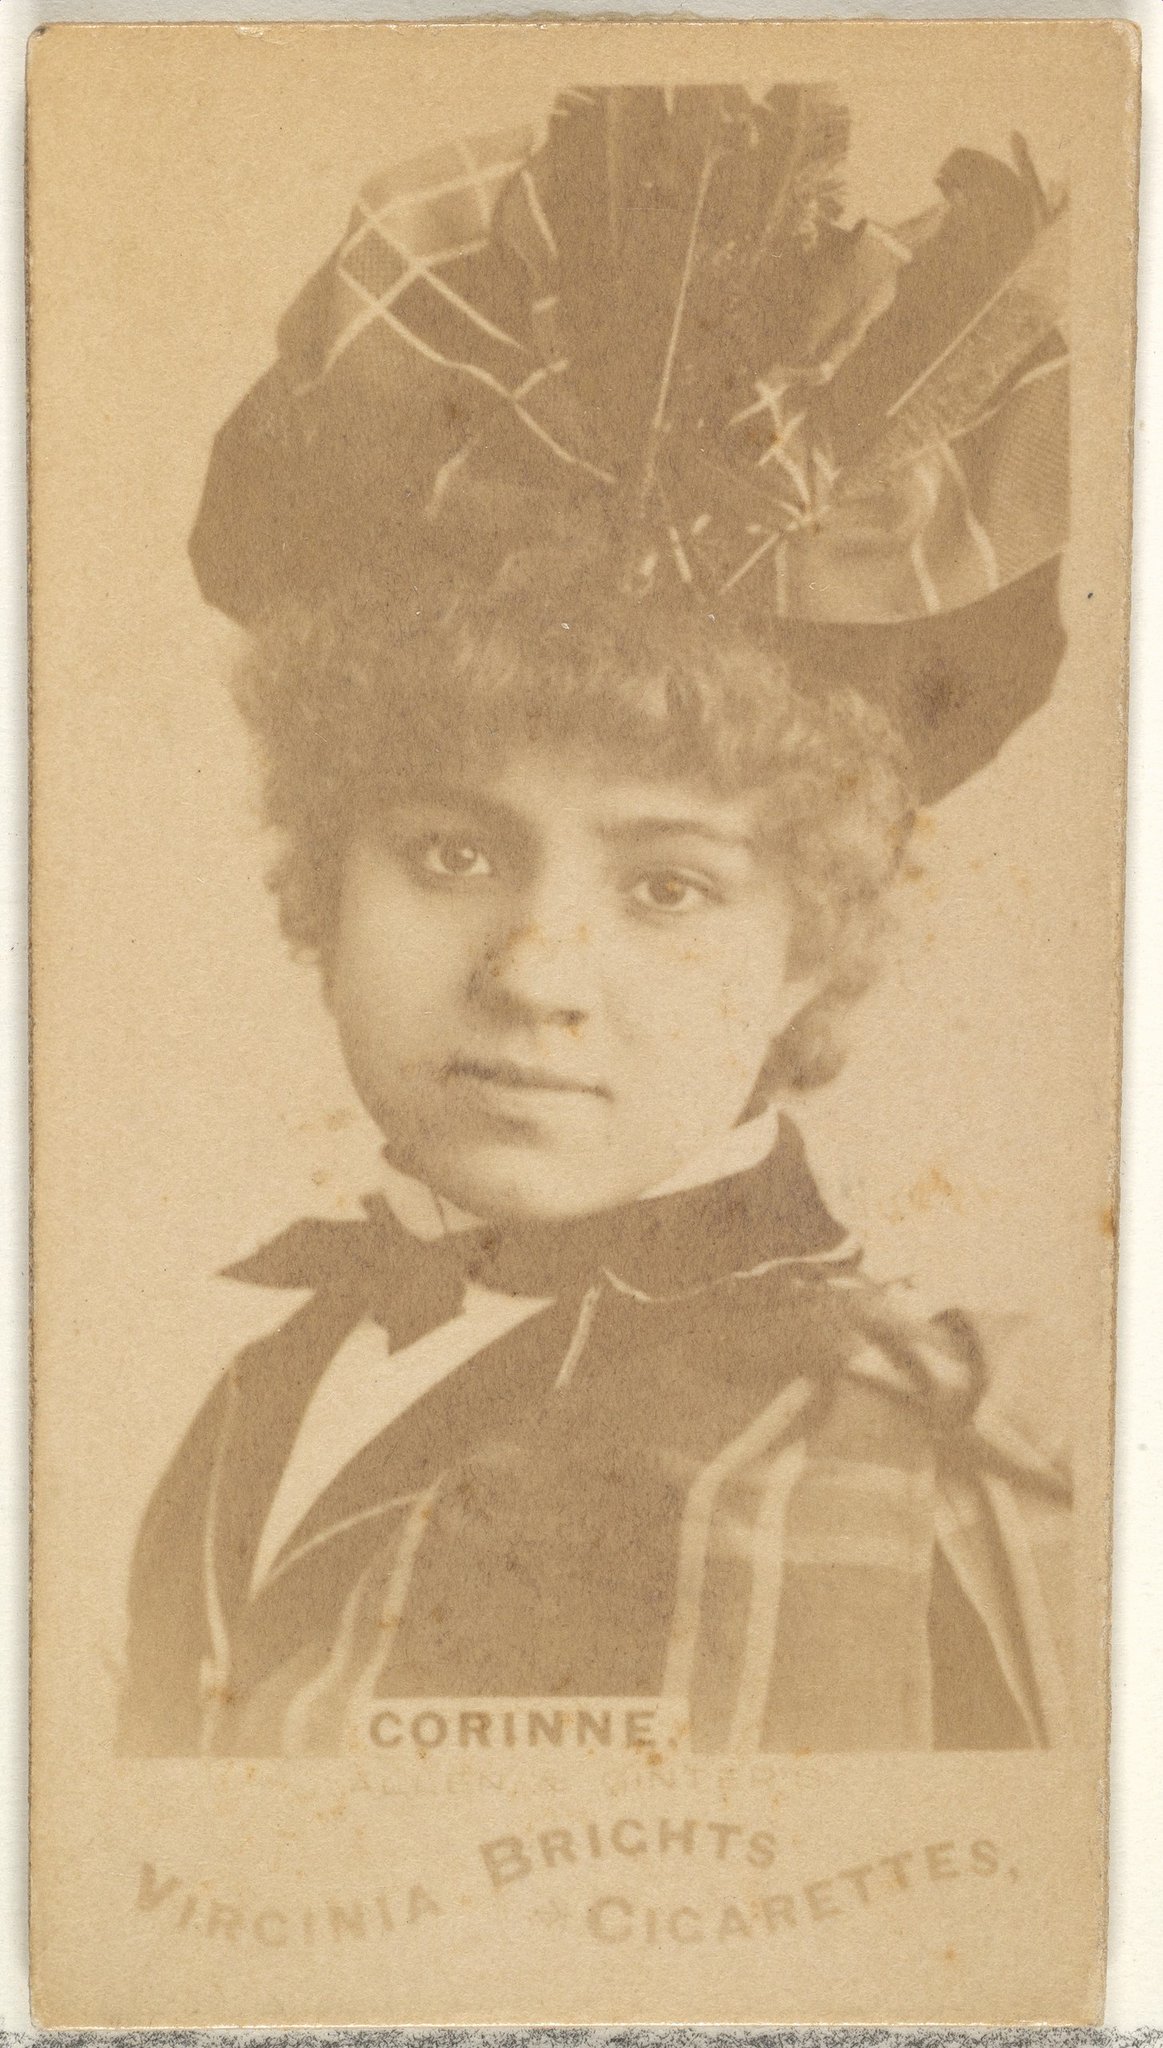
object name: photograph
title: Corinne, from the Actors and Actresses series (N45, Type 1) for Virginia Brights Cigarettes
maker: allen & ginter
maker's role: publisher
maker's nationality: american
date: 1888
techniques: albumen silver print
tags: portraits,women,actresses